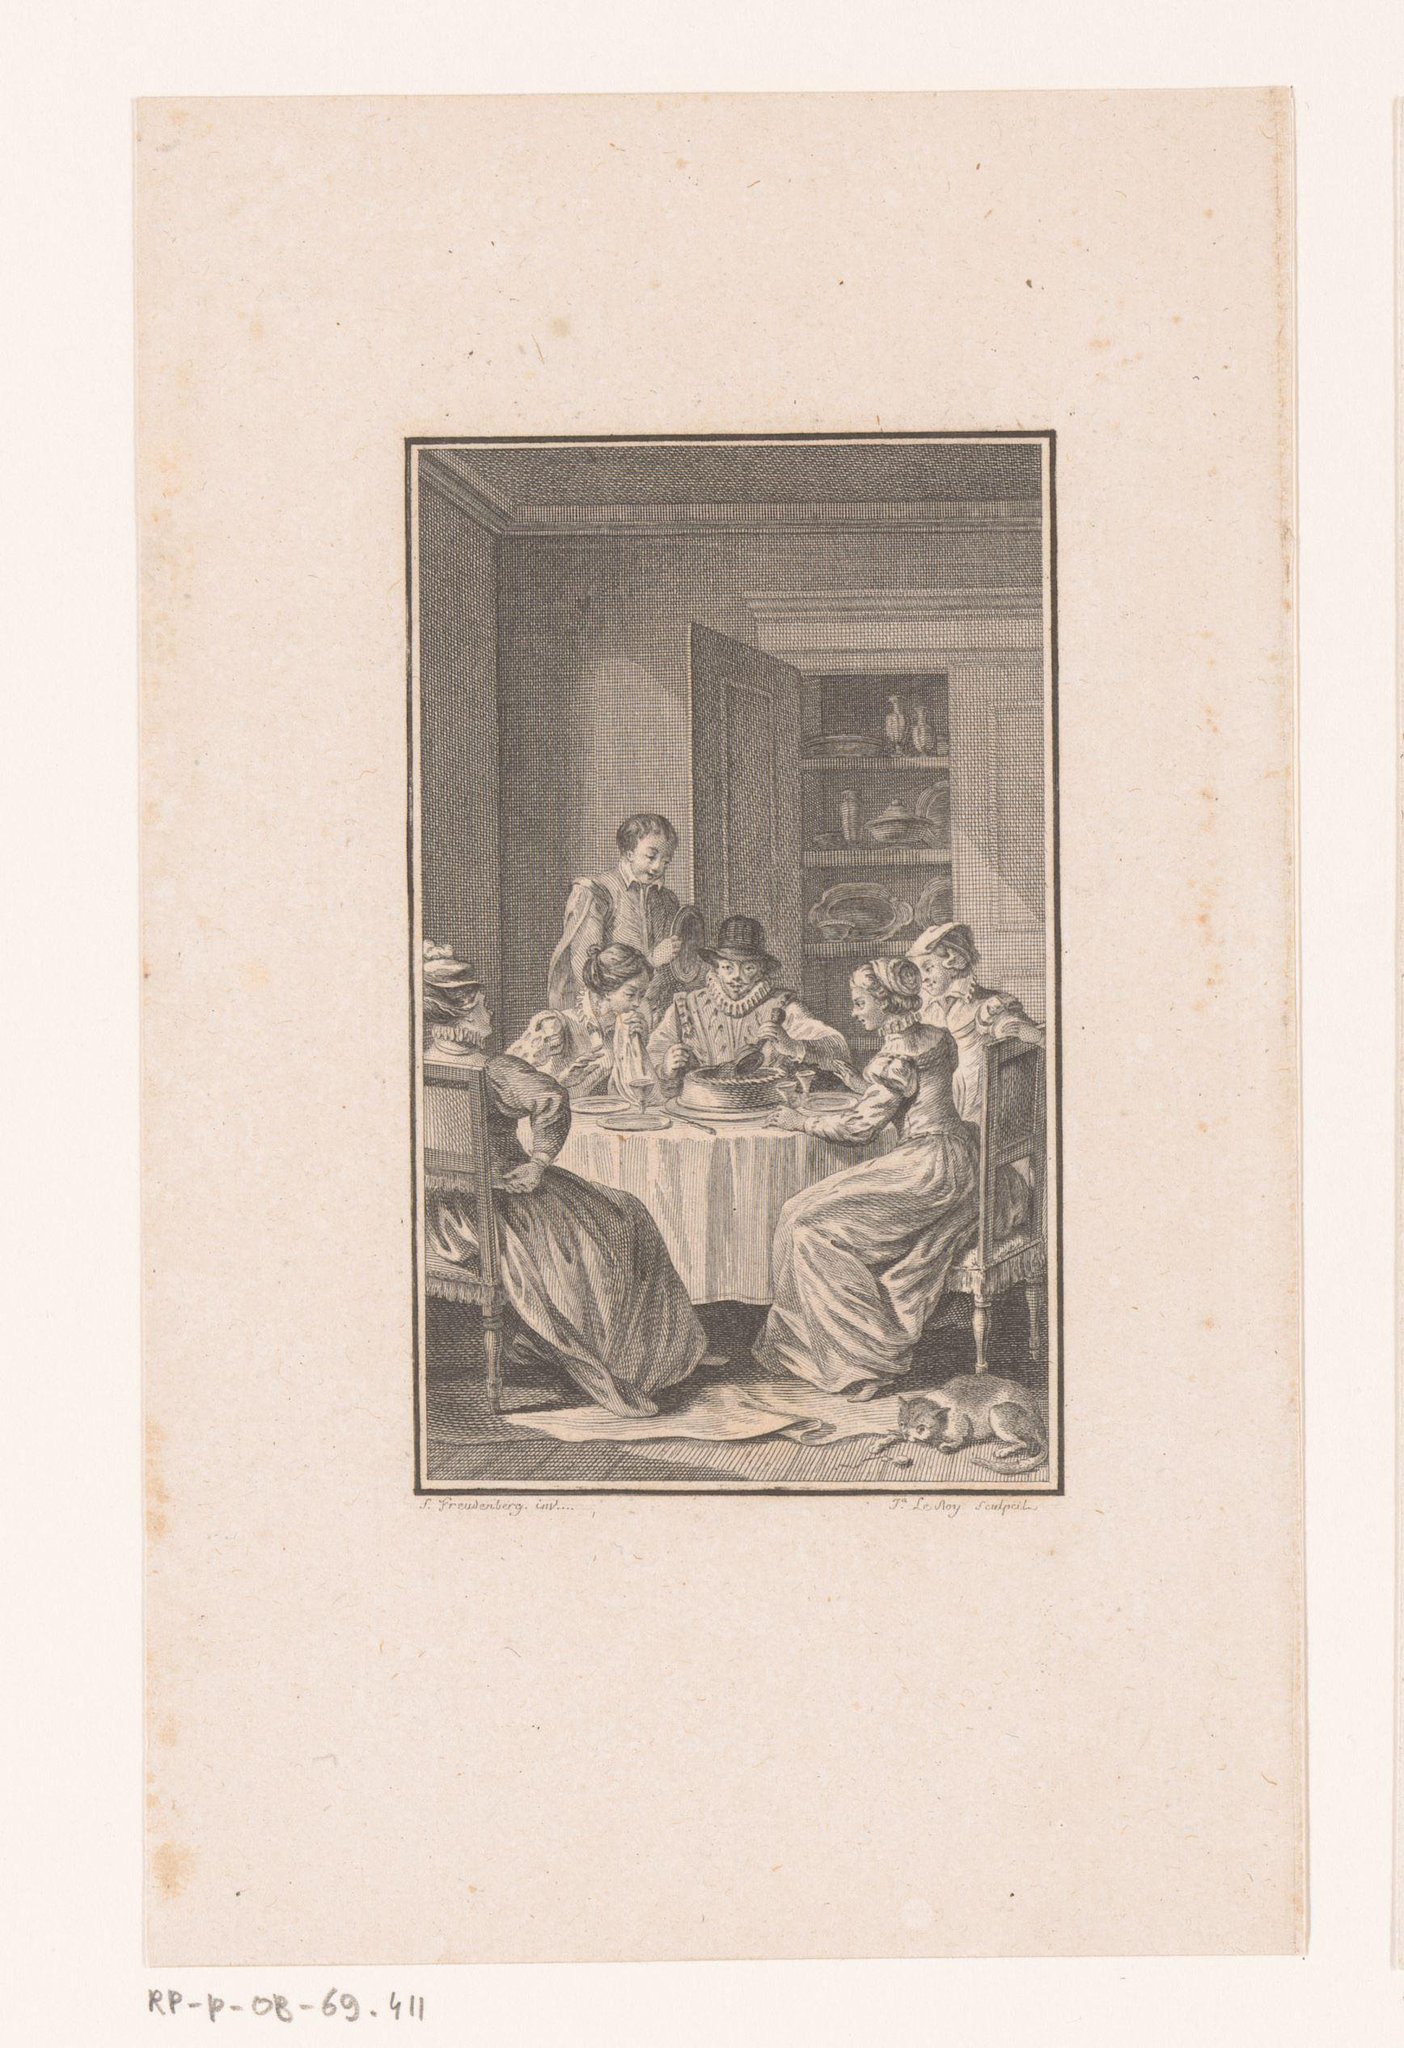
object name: print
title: Interieur met man en vier vrouwen aan een tafel gezeten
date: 1749-1799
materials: paper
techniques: etching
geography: bern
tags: cat, evening meal, dinner, supper, nobility and patriciate; chivalry, knighthood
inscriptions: collector's mark: Lugt 2228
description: Mogelijk prent uit: Les Nouvelles de Marguerite, reine de Navarre. Bern: la nouvelle Société Typographique, 1780-1781.